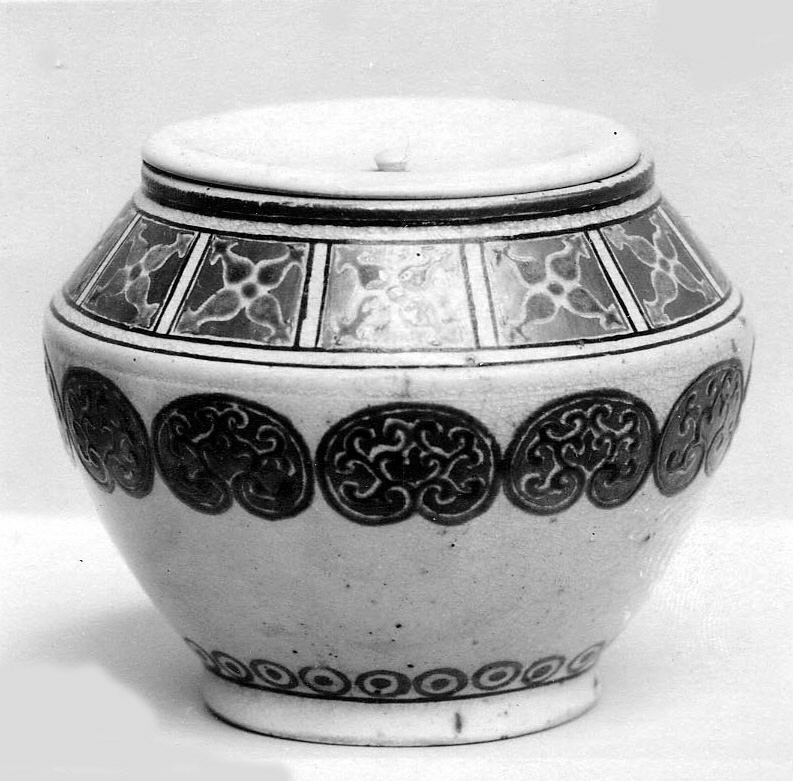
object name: tea jar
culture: japanese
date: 1701-1800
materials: enamel, gold, ivory, pottery